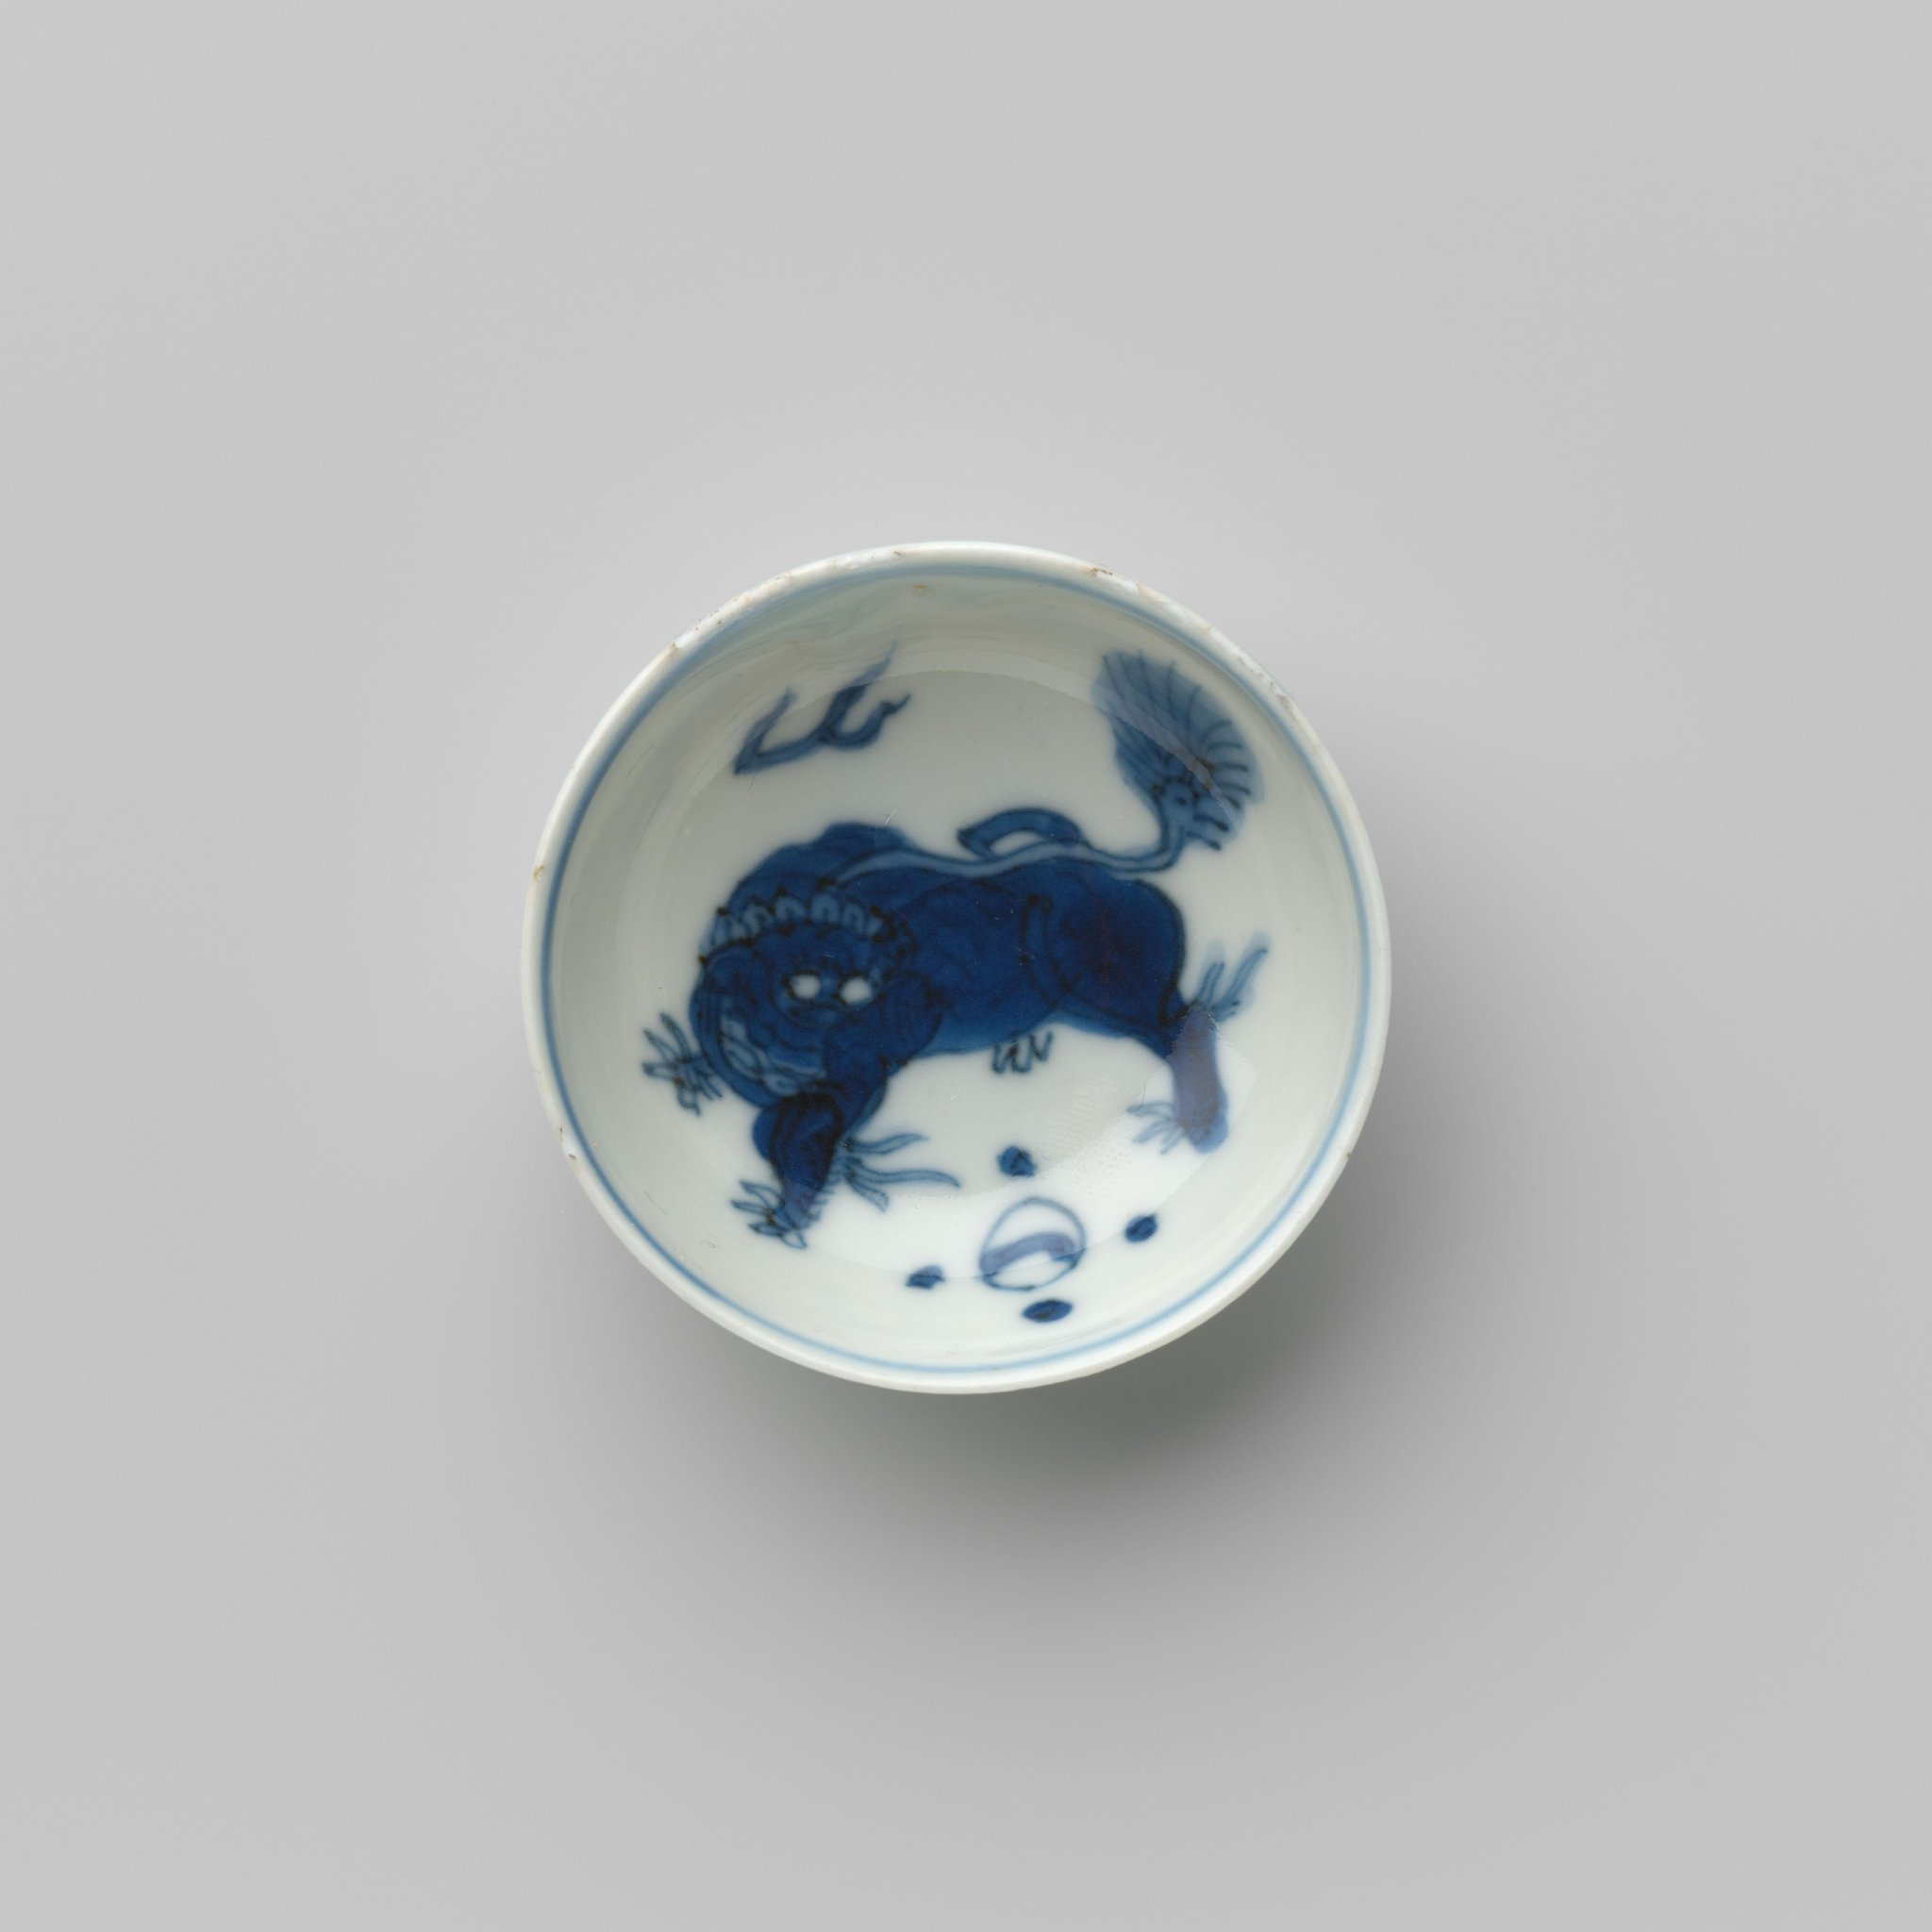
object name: dish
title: Miniature saucer-dish with a shishi and branches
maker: Anonymous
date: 1675-1699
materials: cobalt, glaze, paint, porcelain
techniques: firing, turning, vitrification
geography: china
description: Miniatuur schaal van porselein, beschilderd in onderglazuur blauw. Op het plat een shishi, waaronder een bal. De buitenwand met takken. Blauw-wit.